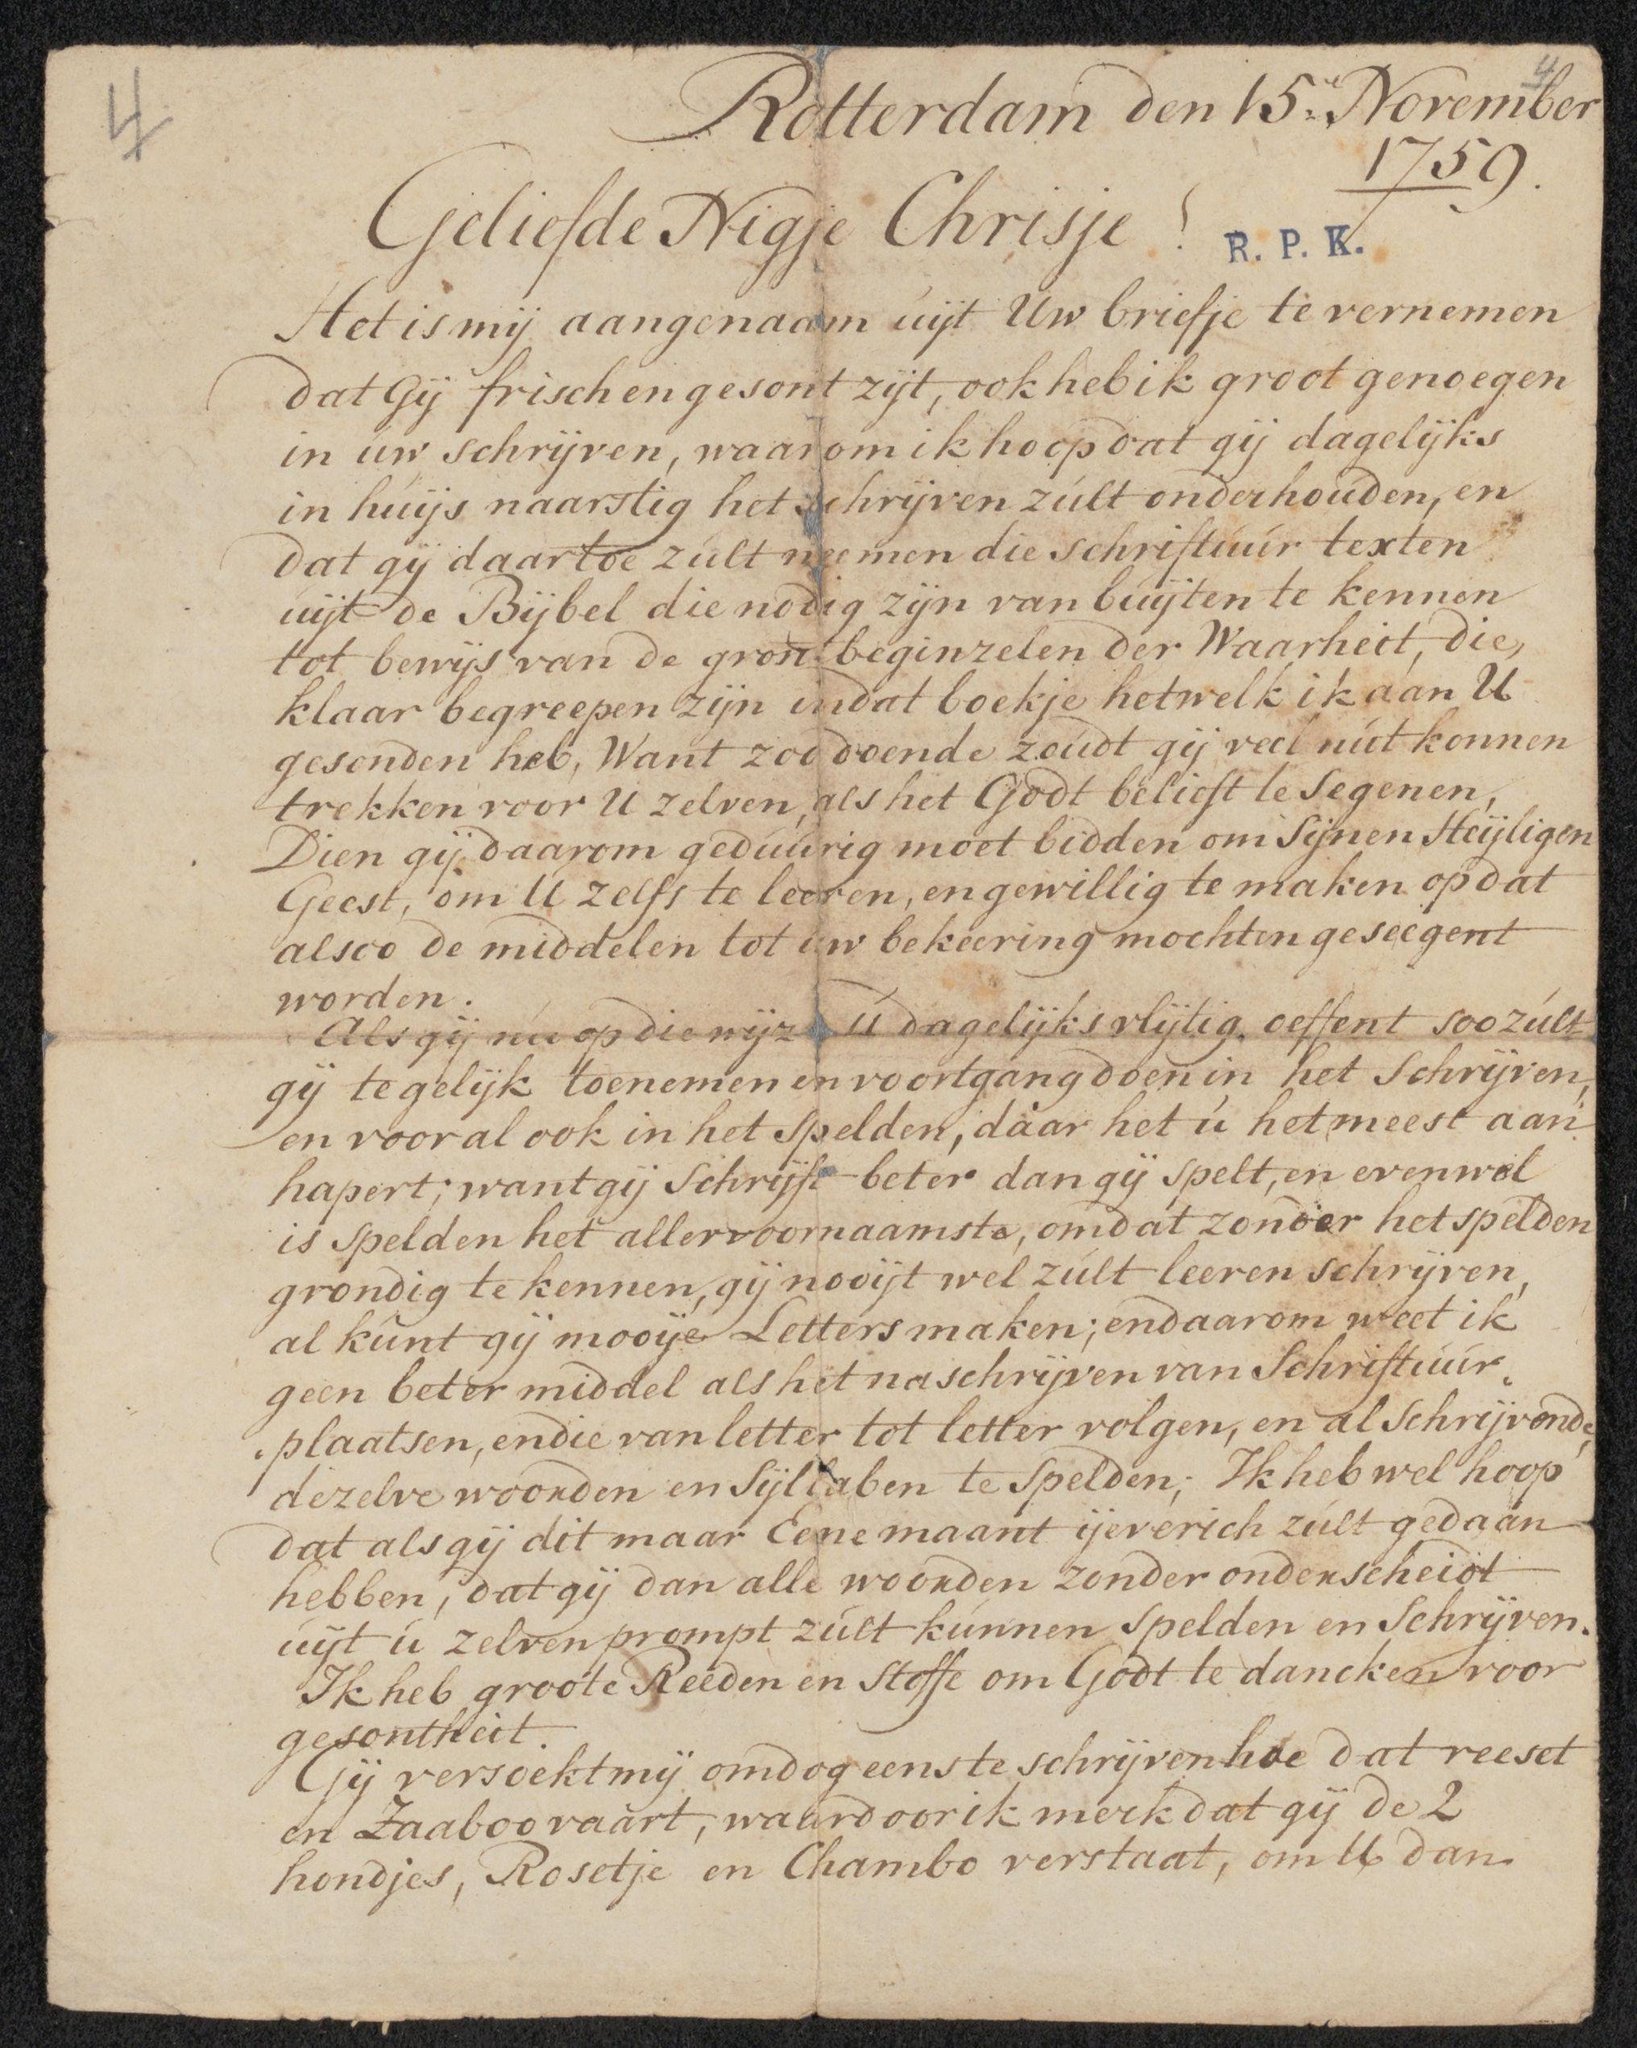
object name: letter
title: Brief aan Christina Sibilla Charlotte Bakhuizen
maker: gerrit backhuijzen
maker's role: draughtsman, painter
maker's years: 1721-1760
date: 1759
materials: ink, paper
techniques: pen, writing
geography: rotterdam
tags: christina sibilla charlotta bakhuizen, christian religion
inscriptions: watermark, collector's mark: Lugt 2233